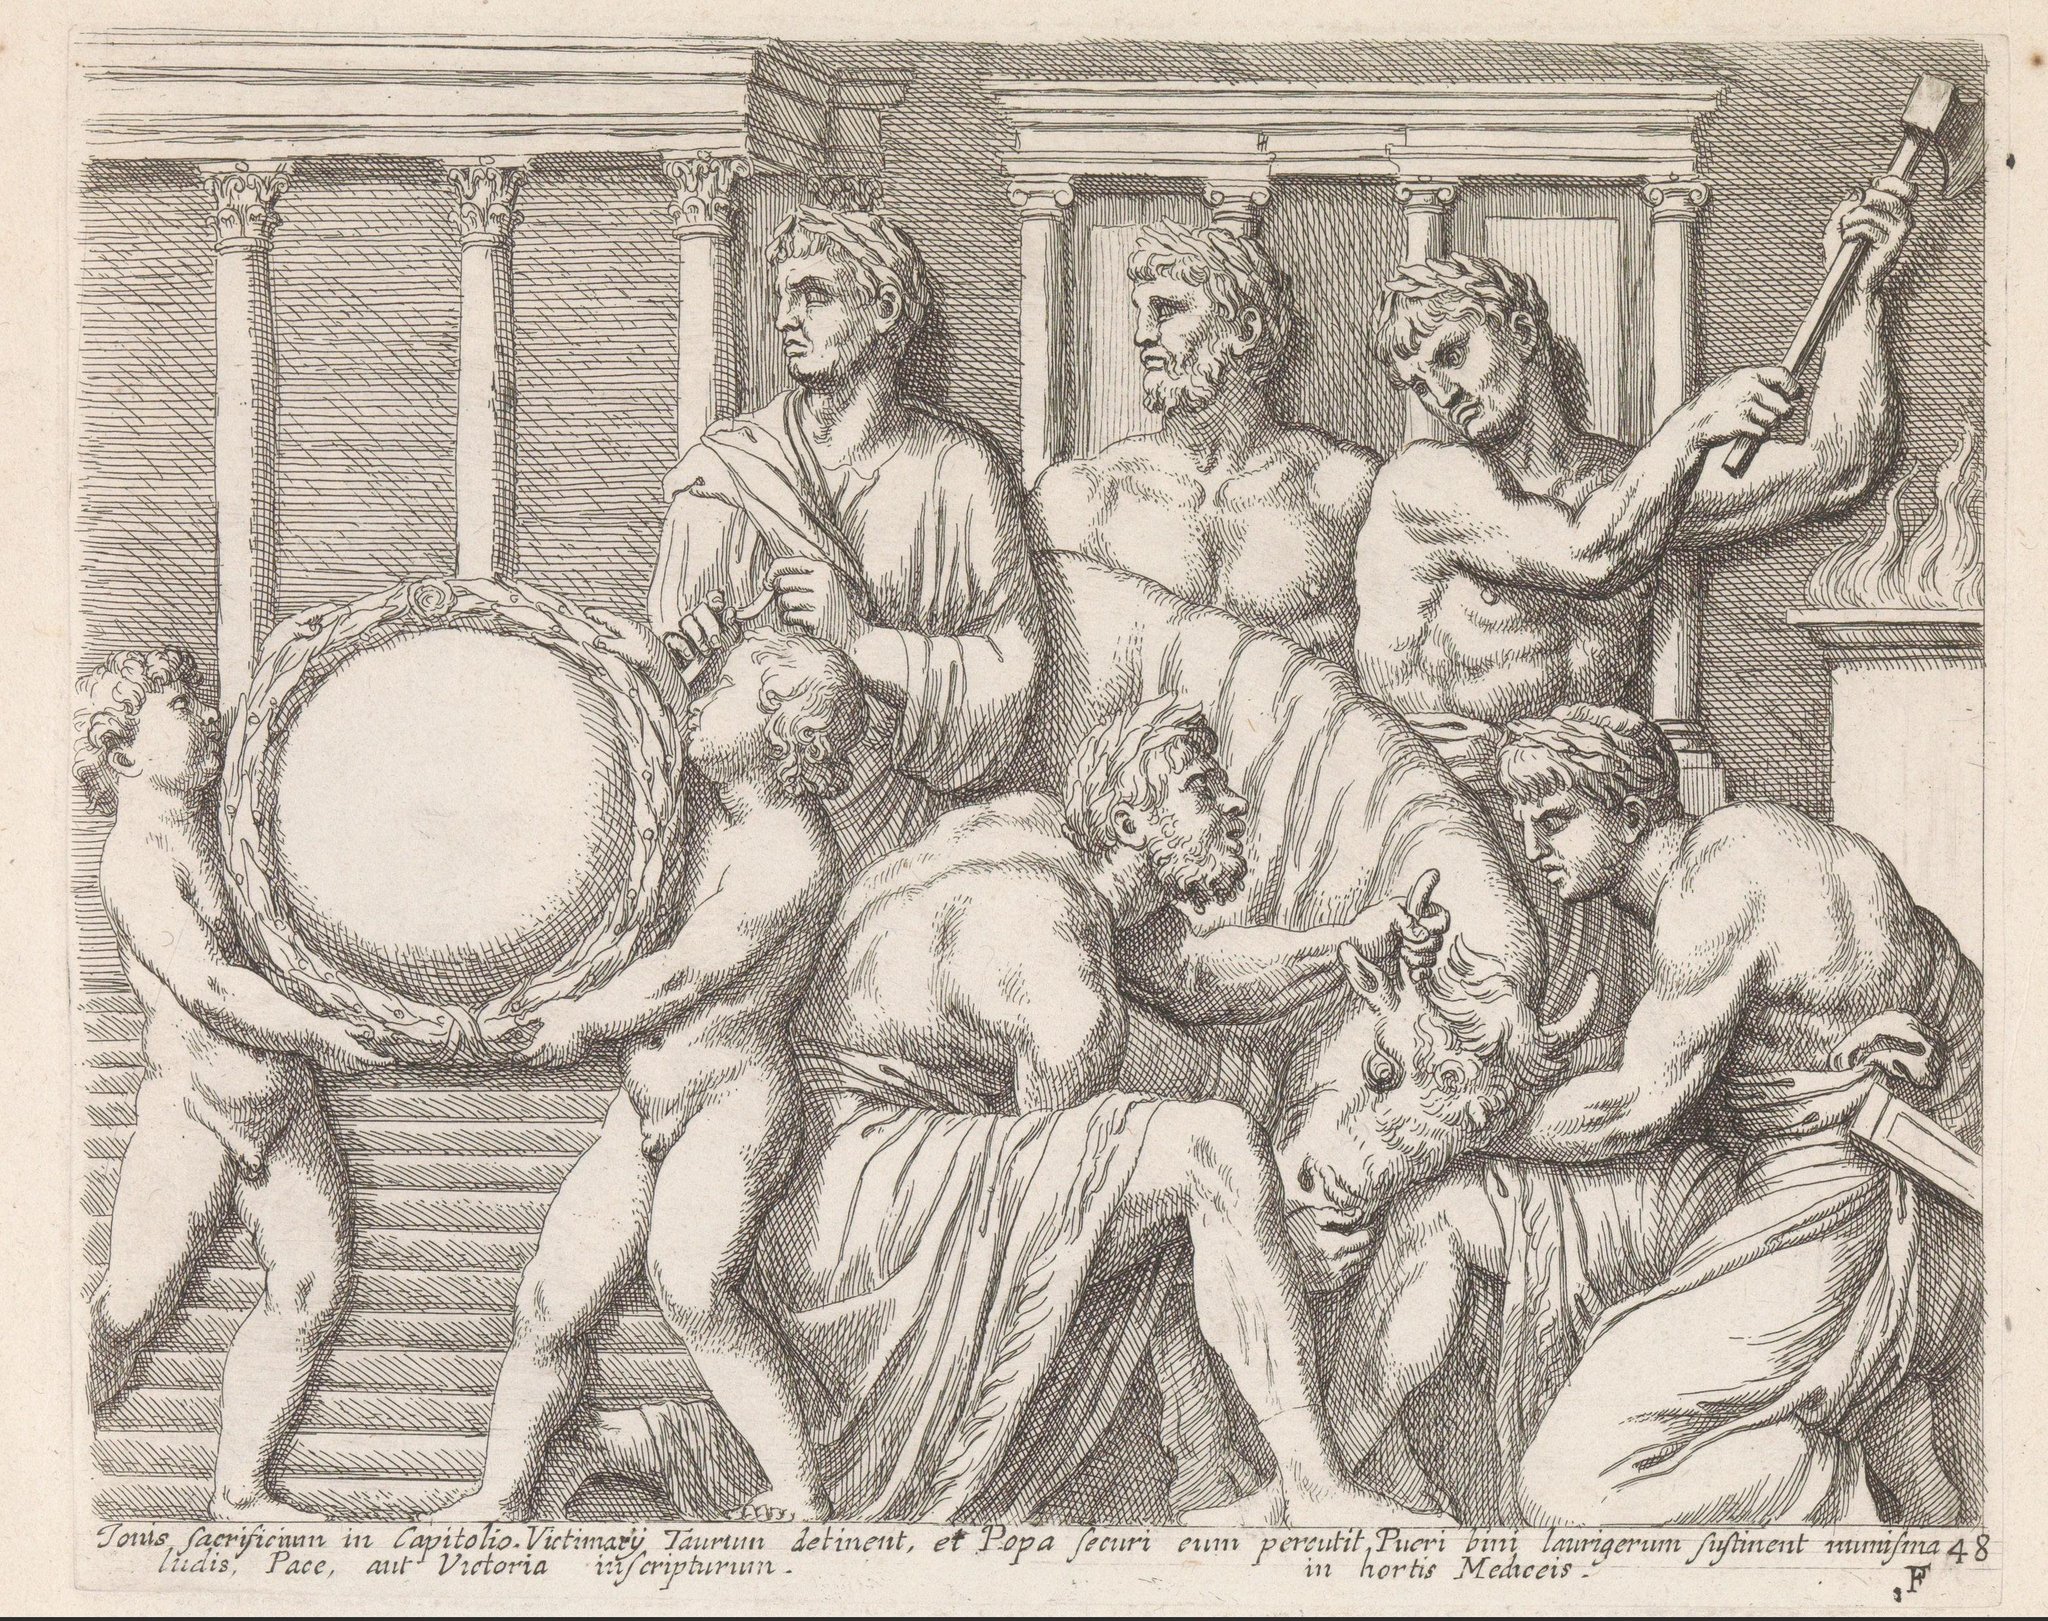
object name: album leaf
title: Romeinse gebeeldhouwde reliëfs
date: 1645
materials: paper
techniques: etching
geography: vatican city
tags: animal sacrifice ~ roman religion, piece of sculpture, reproduction of a piece of sculpture, ox, cupids: 'amores', 'amoretti', 'putti'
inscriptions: inscription: ‘Ende lib. No. 14. fol. 90.’, number: ‘75’, inscription: ‘Ende lib. No. 6. tom. 2. no. 58.’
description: Deze prent maakt deel uit van een reeks van 54 prenten (+ titelprent) naar antieke reliëfs. De nummering op de prenten loopt van 1 tot en met 50. Sommige prenten hebben dubbele nummers. Naar een reliëf in de Villa Medici te Rome.